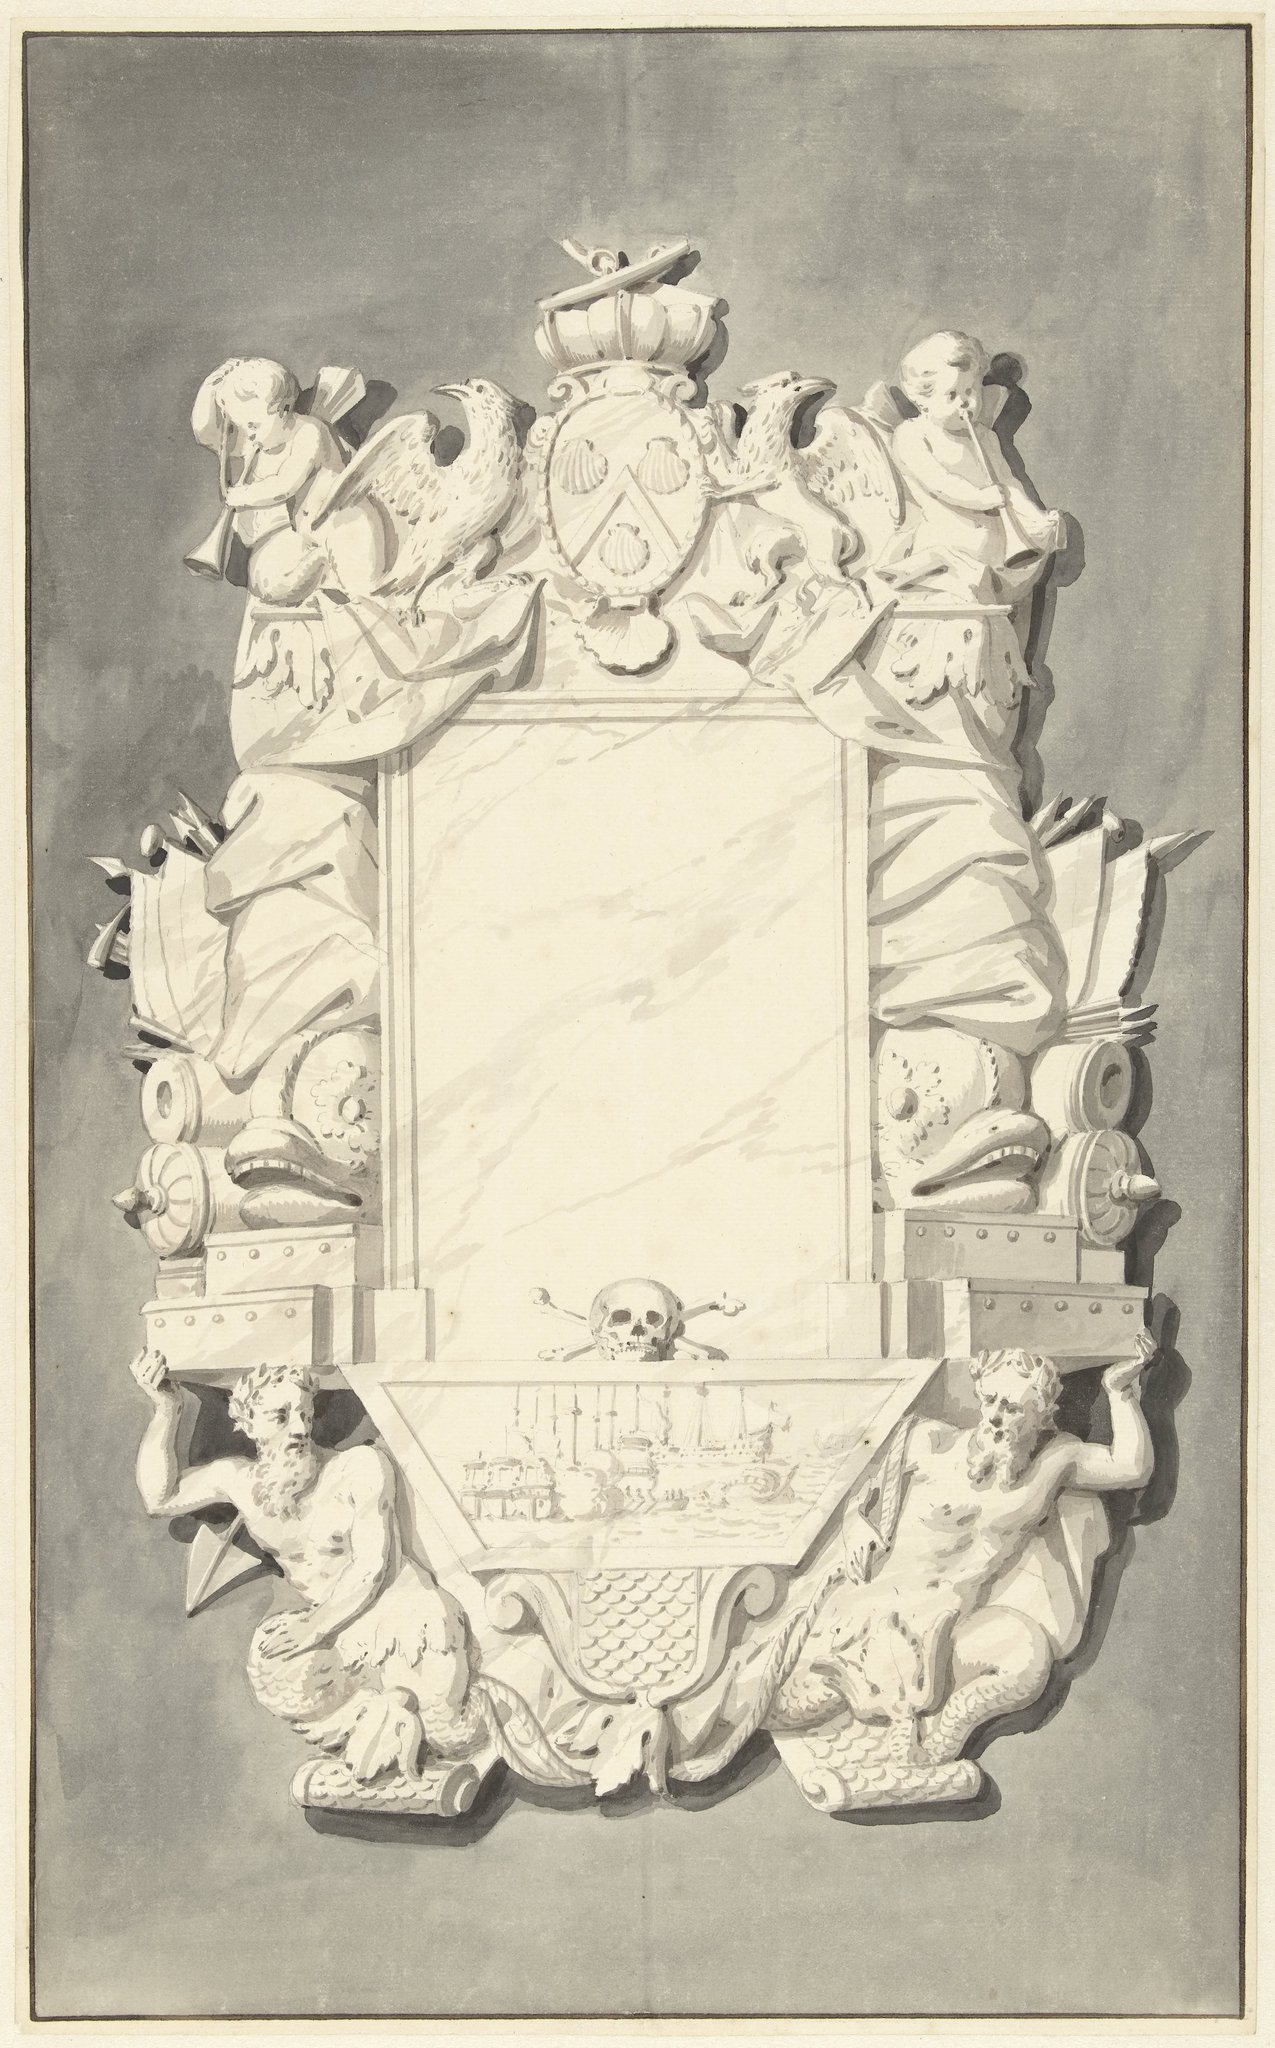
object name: drawing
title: Grafmonument van Anthony Pieterson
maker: gerrit lamberts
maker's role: bookseller, draughtsman, print maker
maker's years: 1776-1850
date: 1786-1850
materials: paper, pencil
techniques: brush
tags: grave-building, monumental tomb